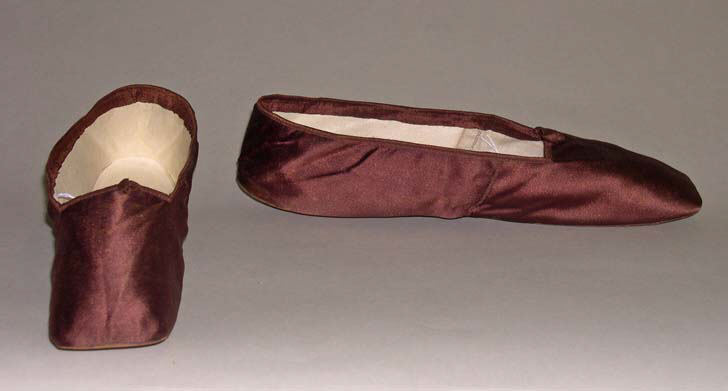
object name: shoe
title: Shoes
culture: american or european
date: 1840-1849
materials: silk